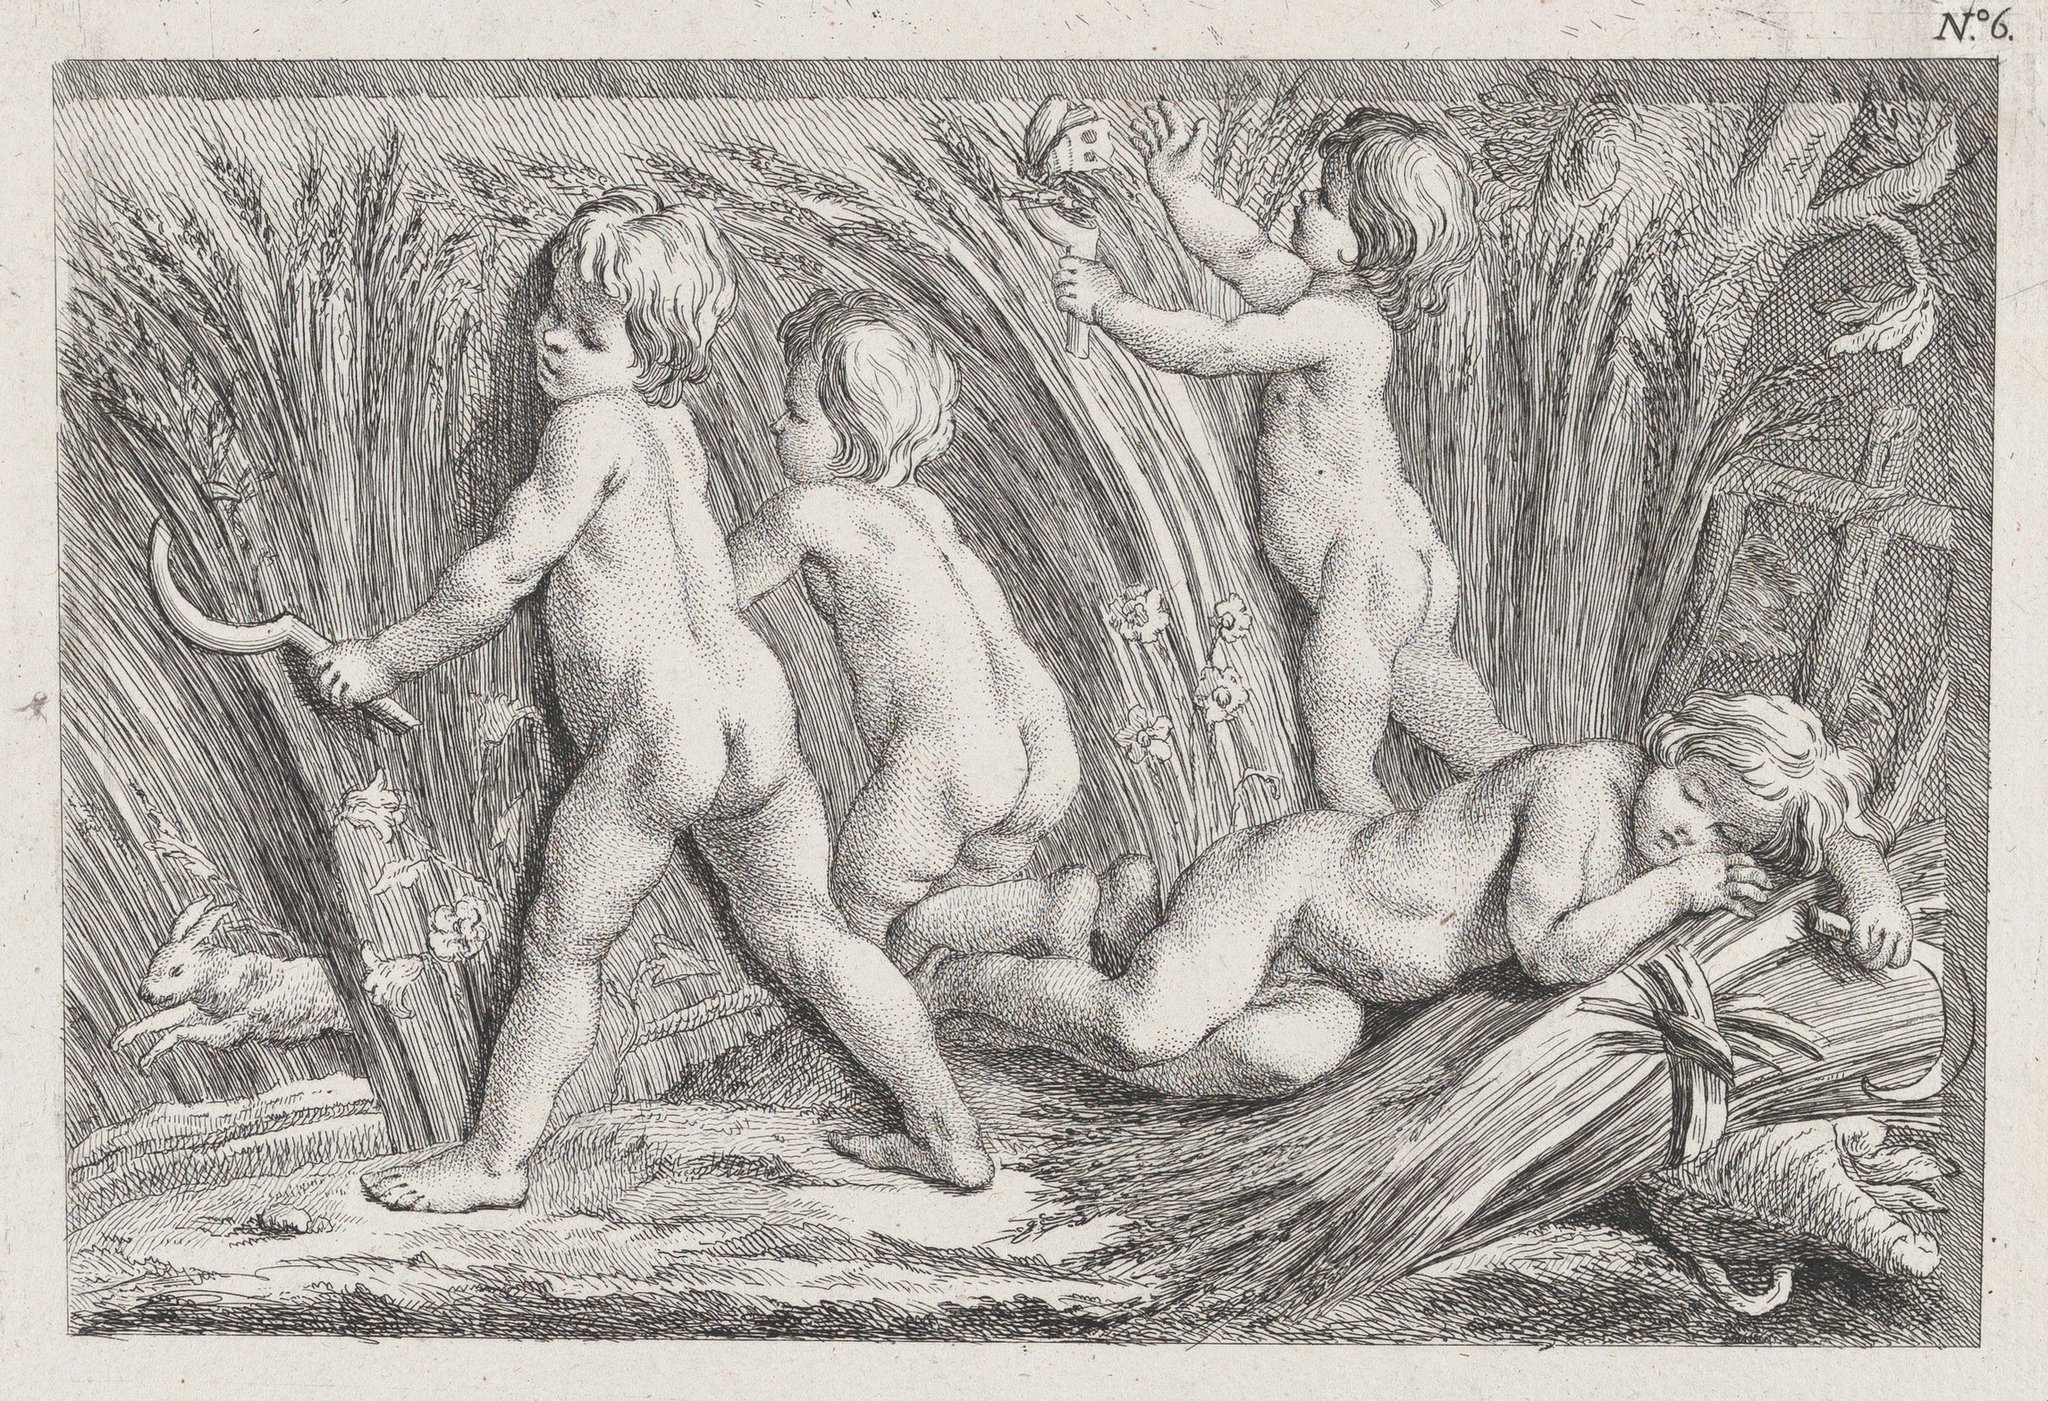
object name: print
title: Nude children shearing wheat; an allegory of Summer; after a bas-relief on the Fontaine des Quatre-Saisons (Paris)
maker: Anonymous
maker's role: artist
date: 1745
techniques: etching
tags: boys,rabbits